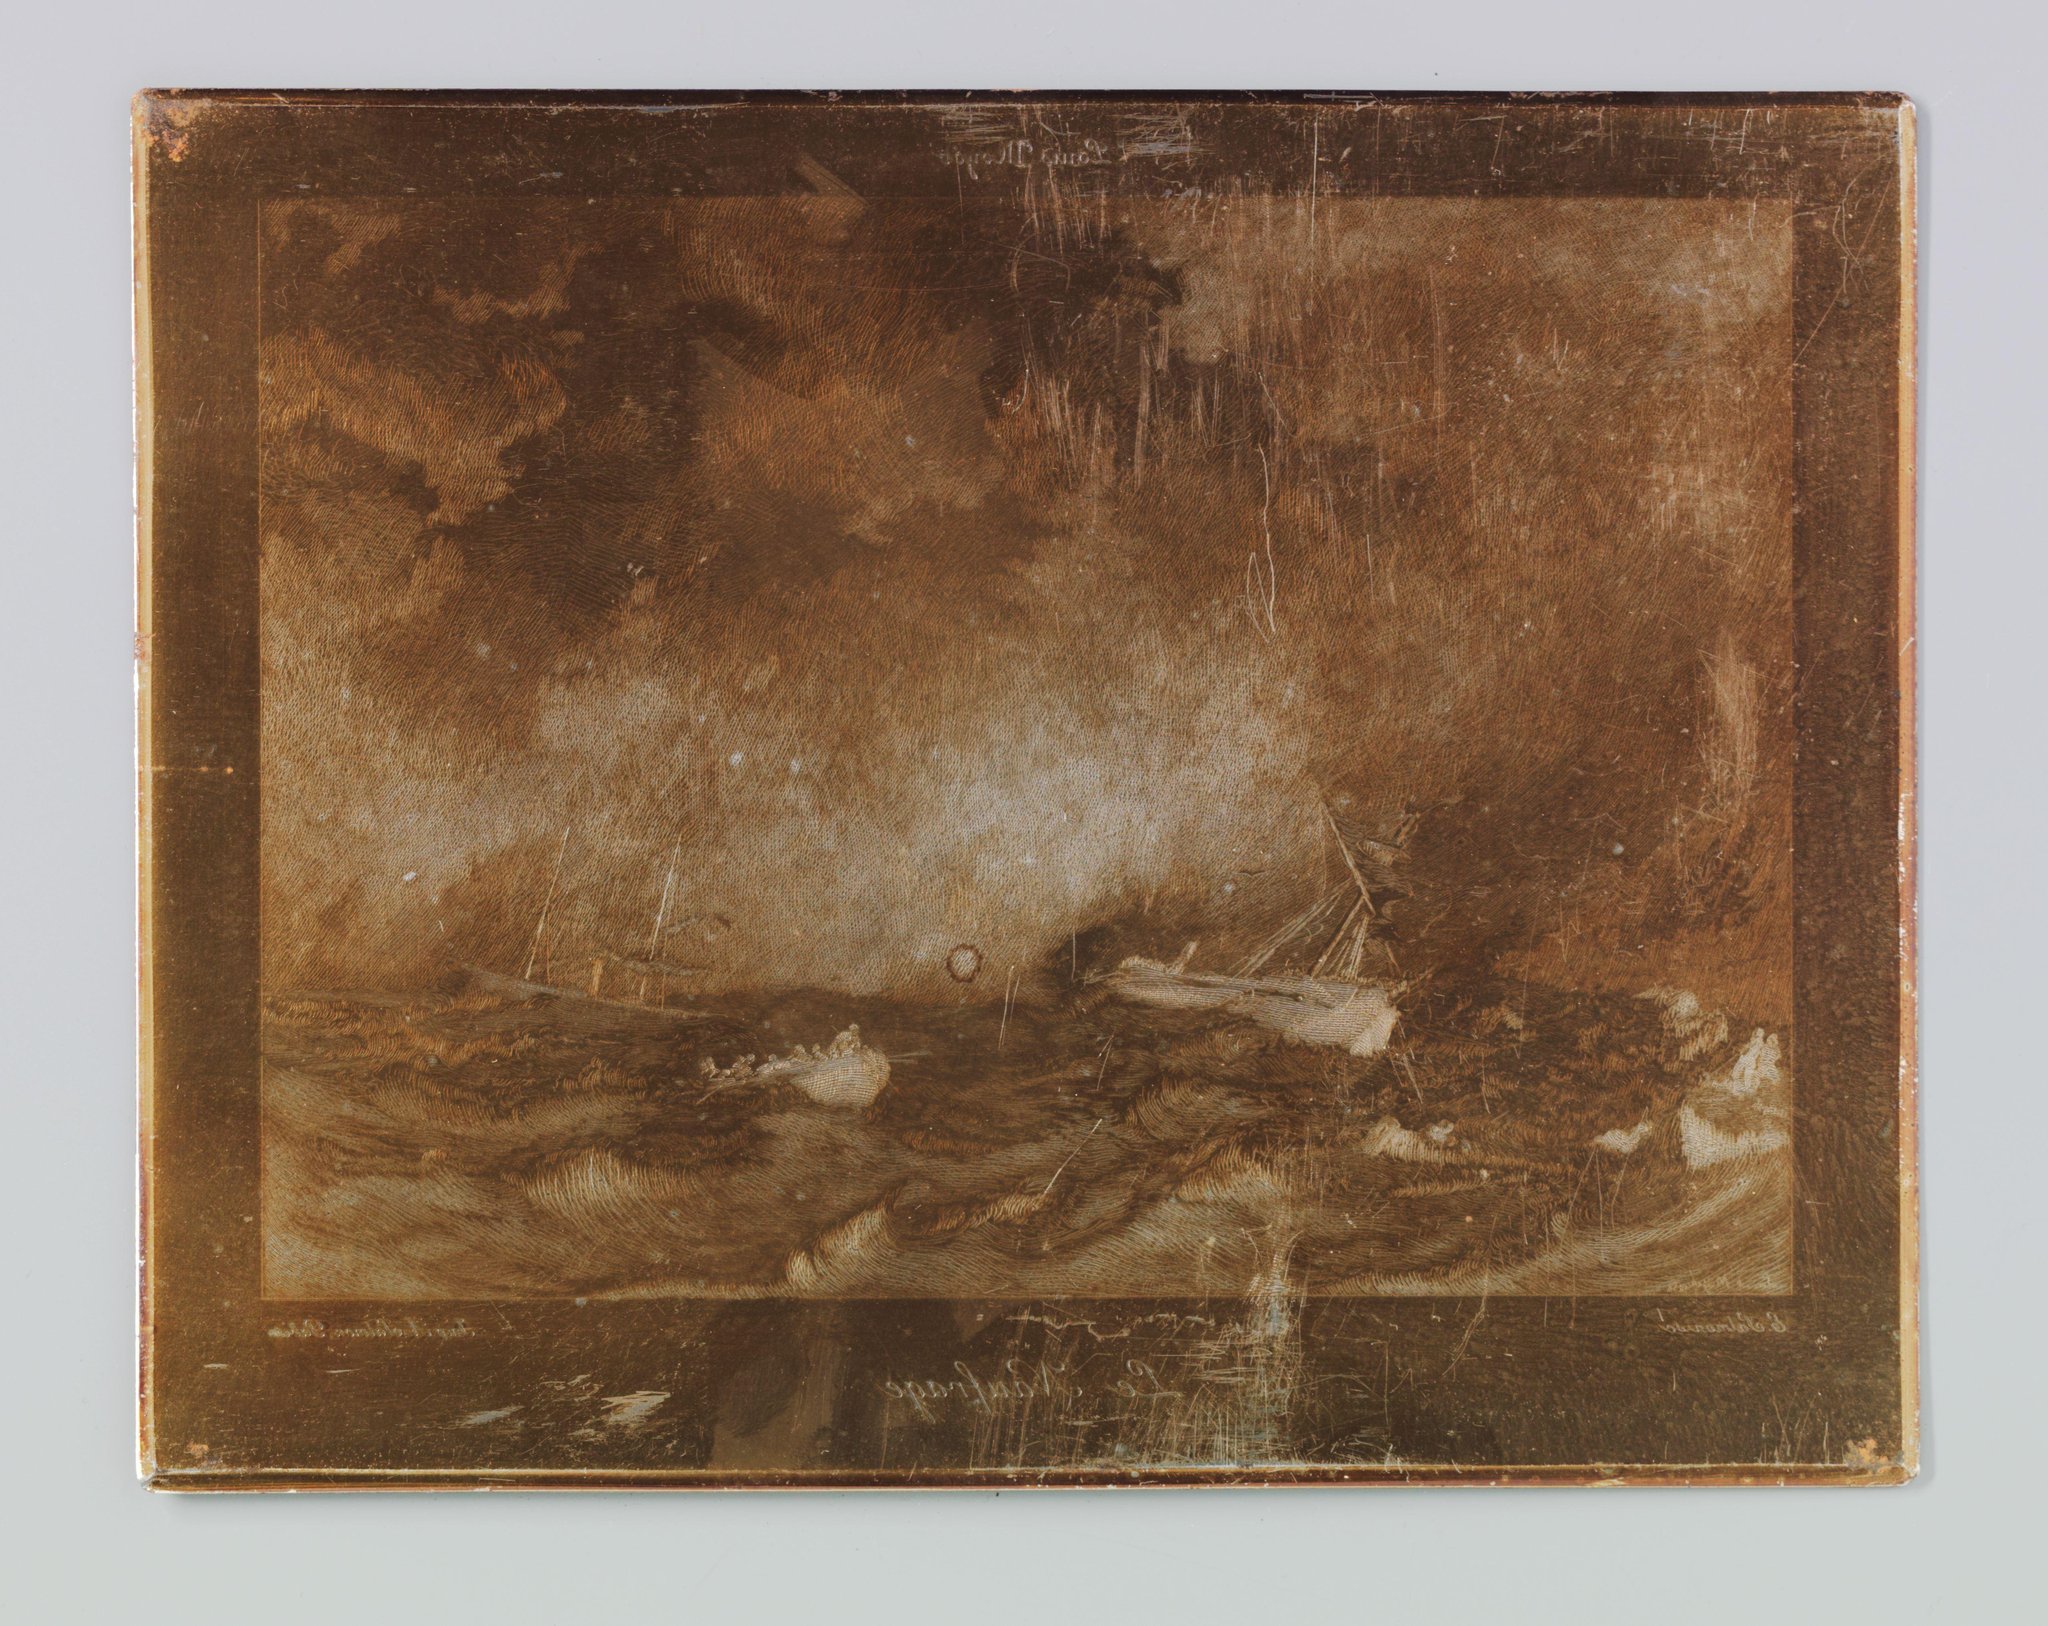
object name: staalplaat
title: Schipbreuk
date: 1850-1913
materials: steel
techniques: etching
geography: paris